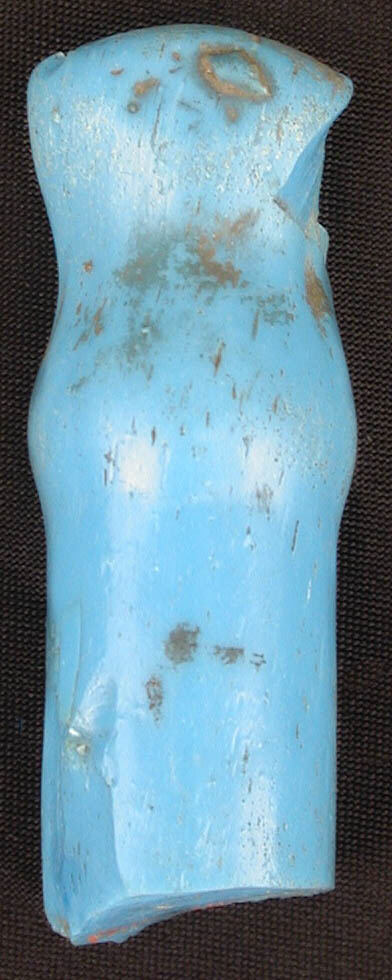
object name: fragment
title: Fragment of a Column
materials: glass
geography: egypt